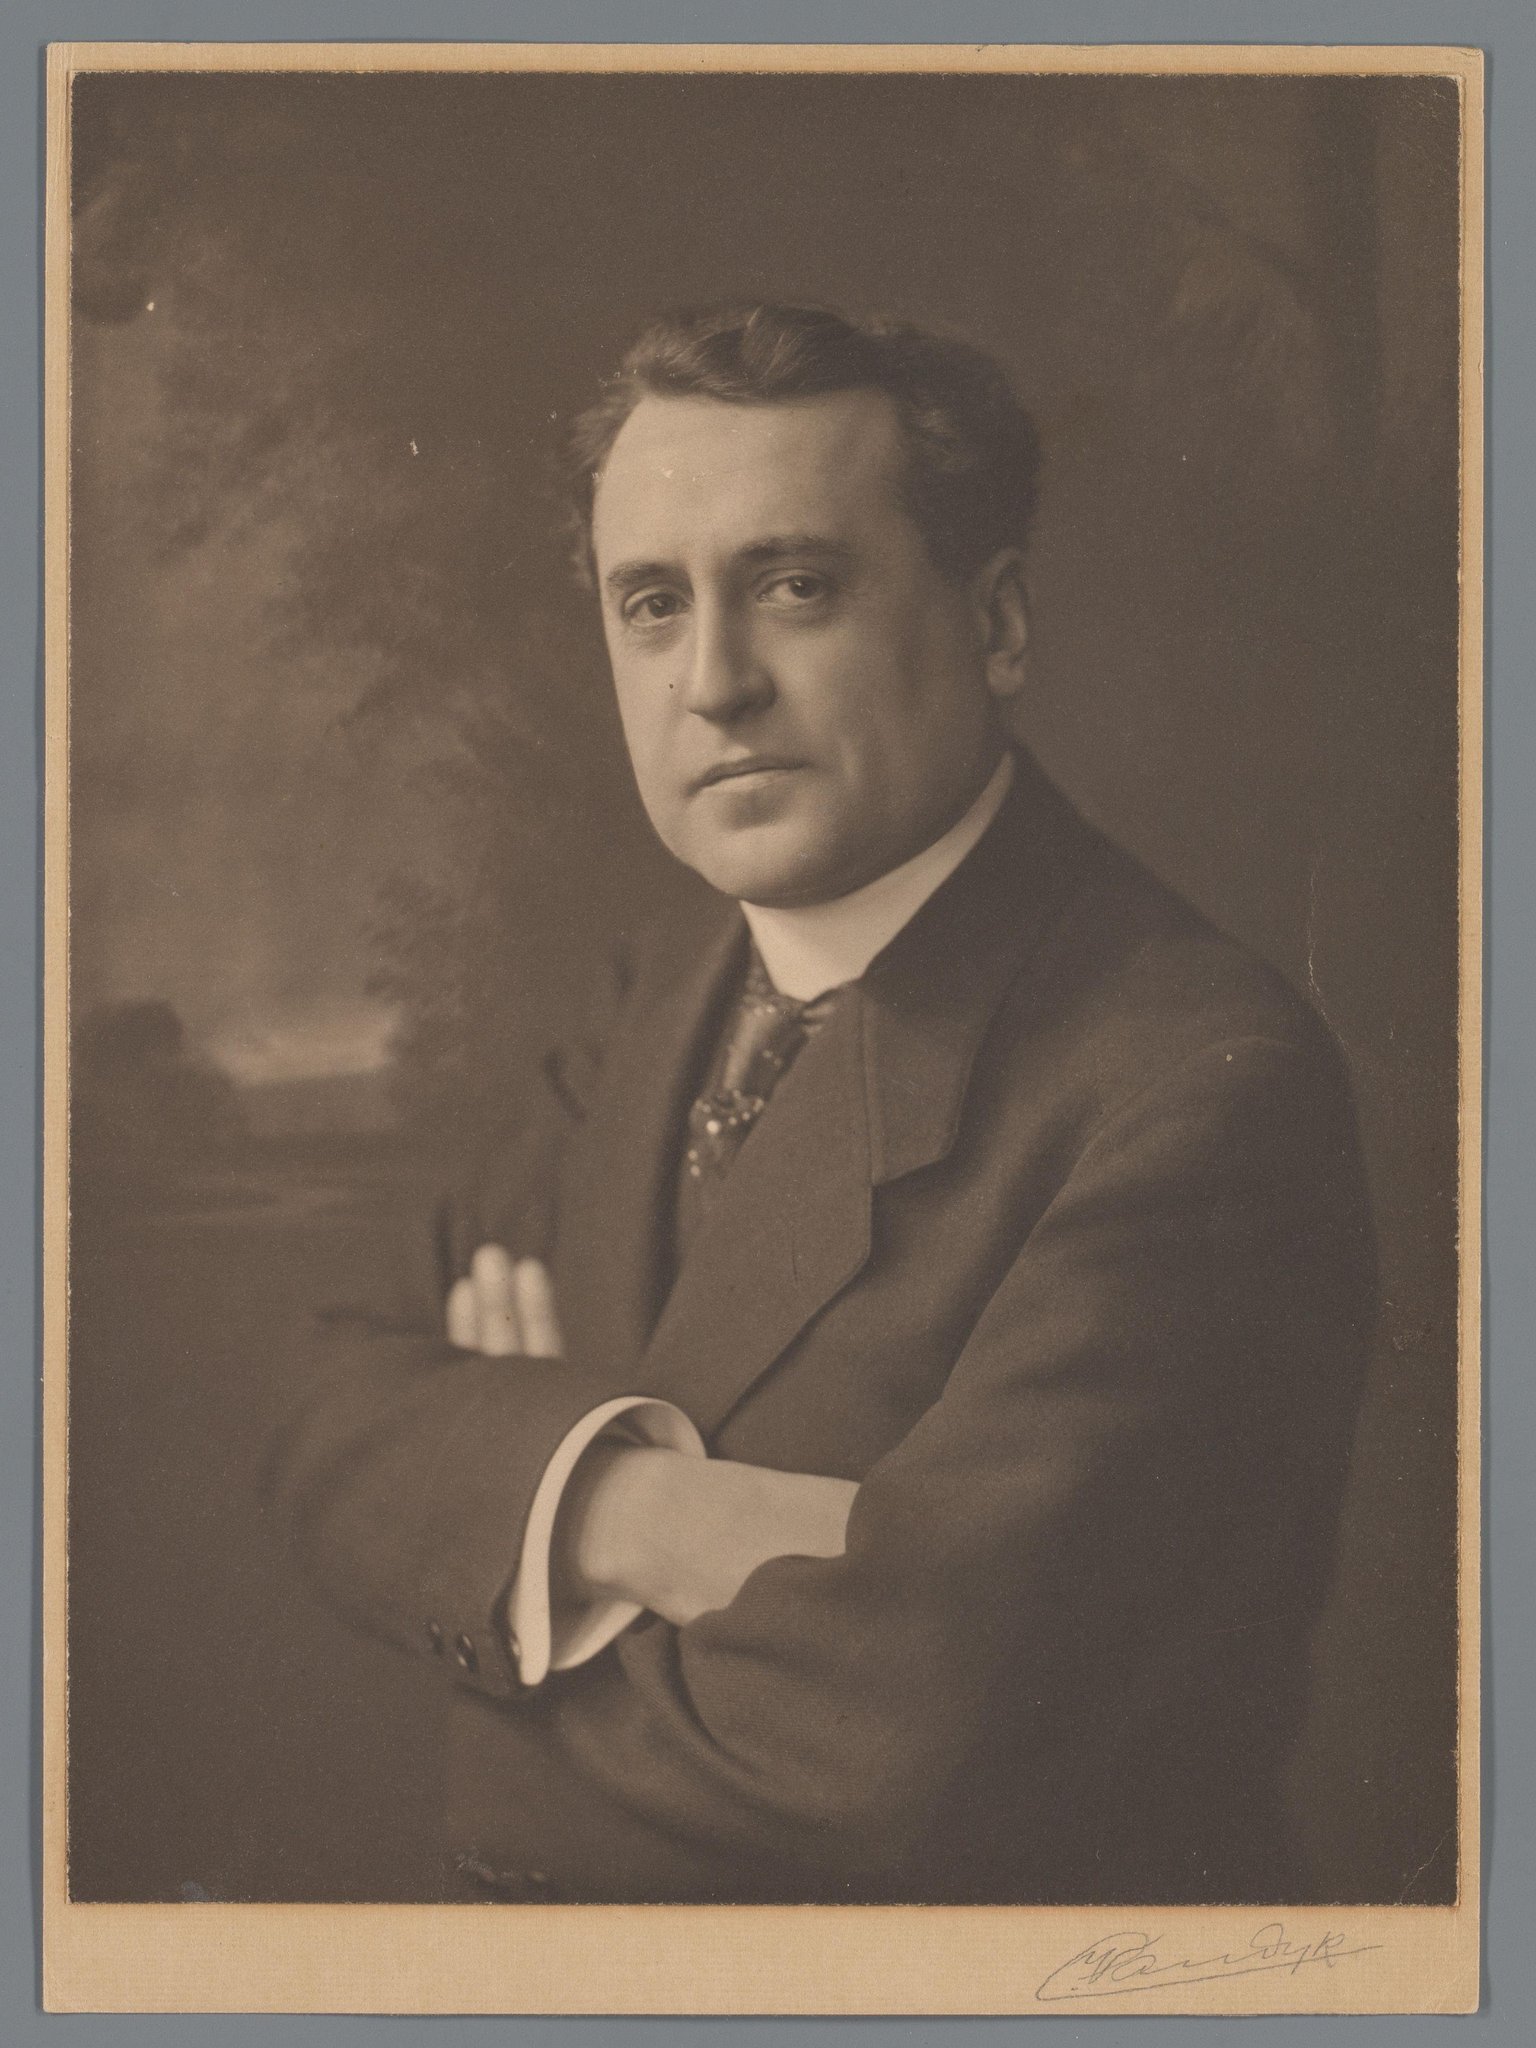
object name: photograph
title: Portret van Jean Buysson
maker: carl vandyk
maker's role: fotograaf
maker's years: 1851-1931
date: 1913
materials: cardboard, paper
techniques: palladium process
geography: london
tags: amsterdam, paris, historical persons (portraits and scenes from the life)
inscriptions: number: ‘13880B [?]’